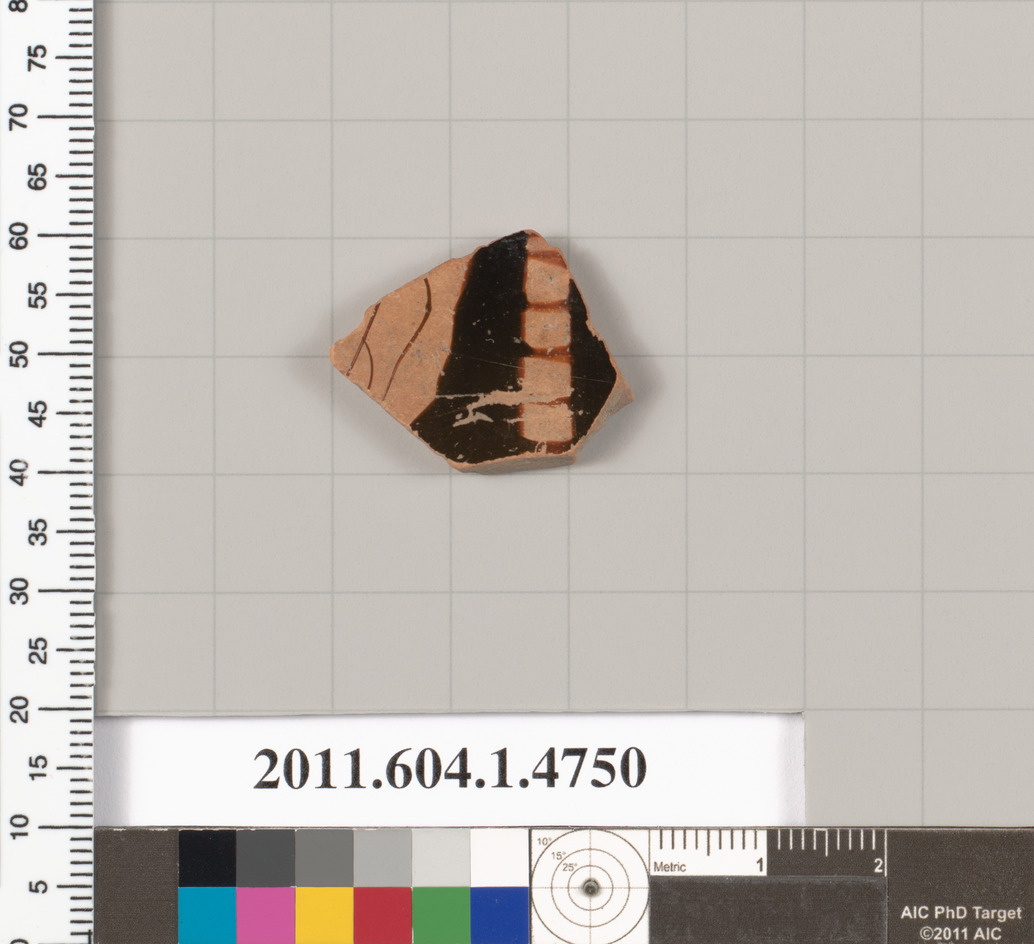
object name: kylix fragment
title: Terracotta fragment of a kylix (drinking cup)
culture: greek, attic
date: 467-435 BCE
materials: terracotta